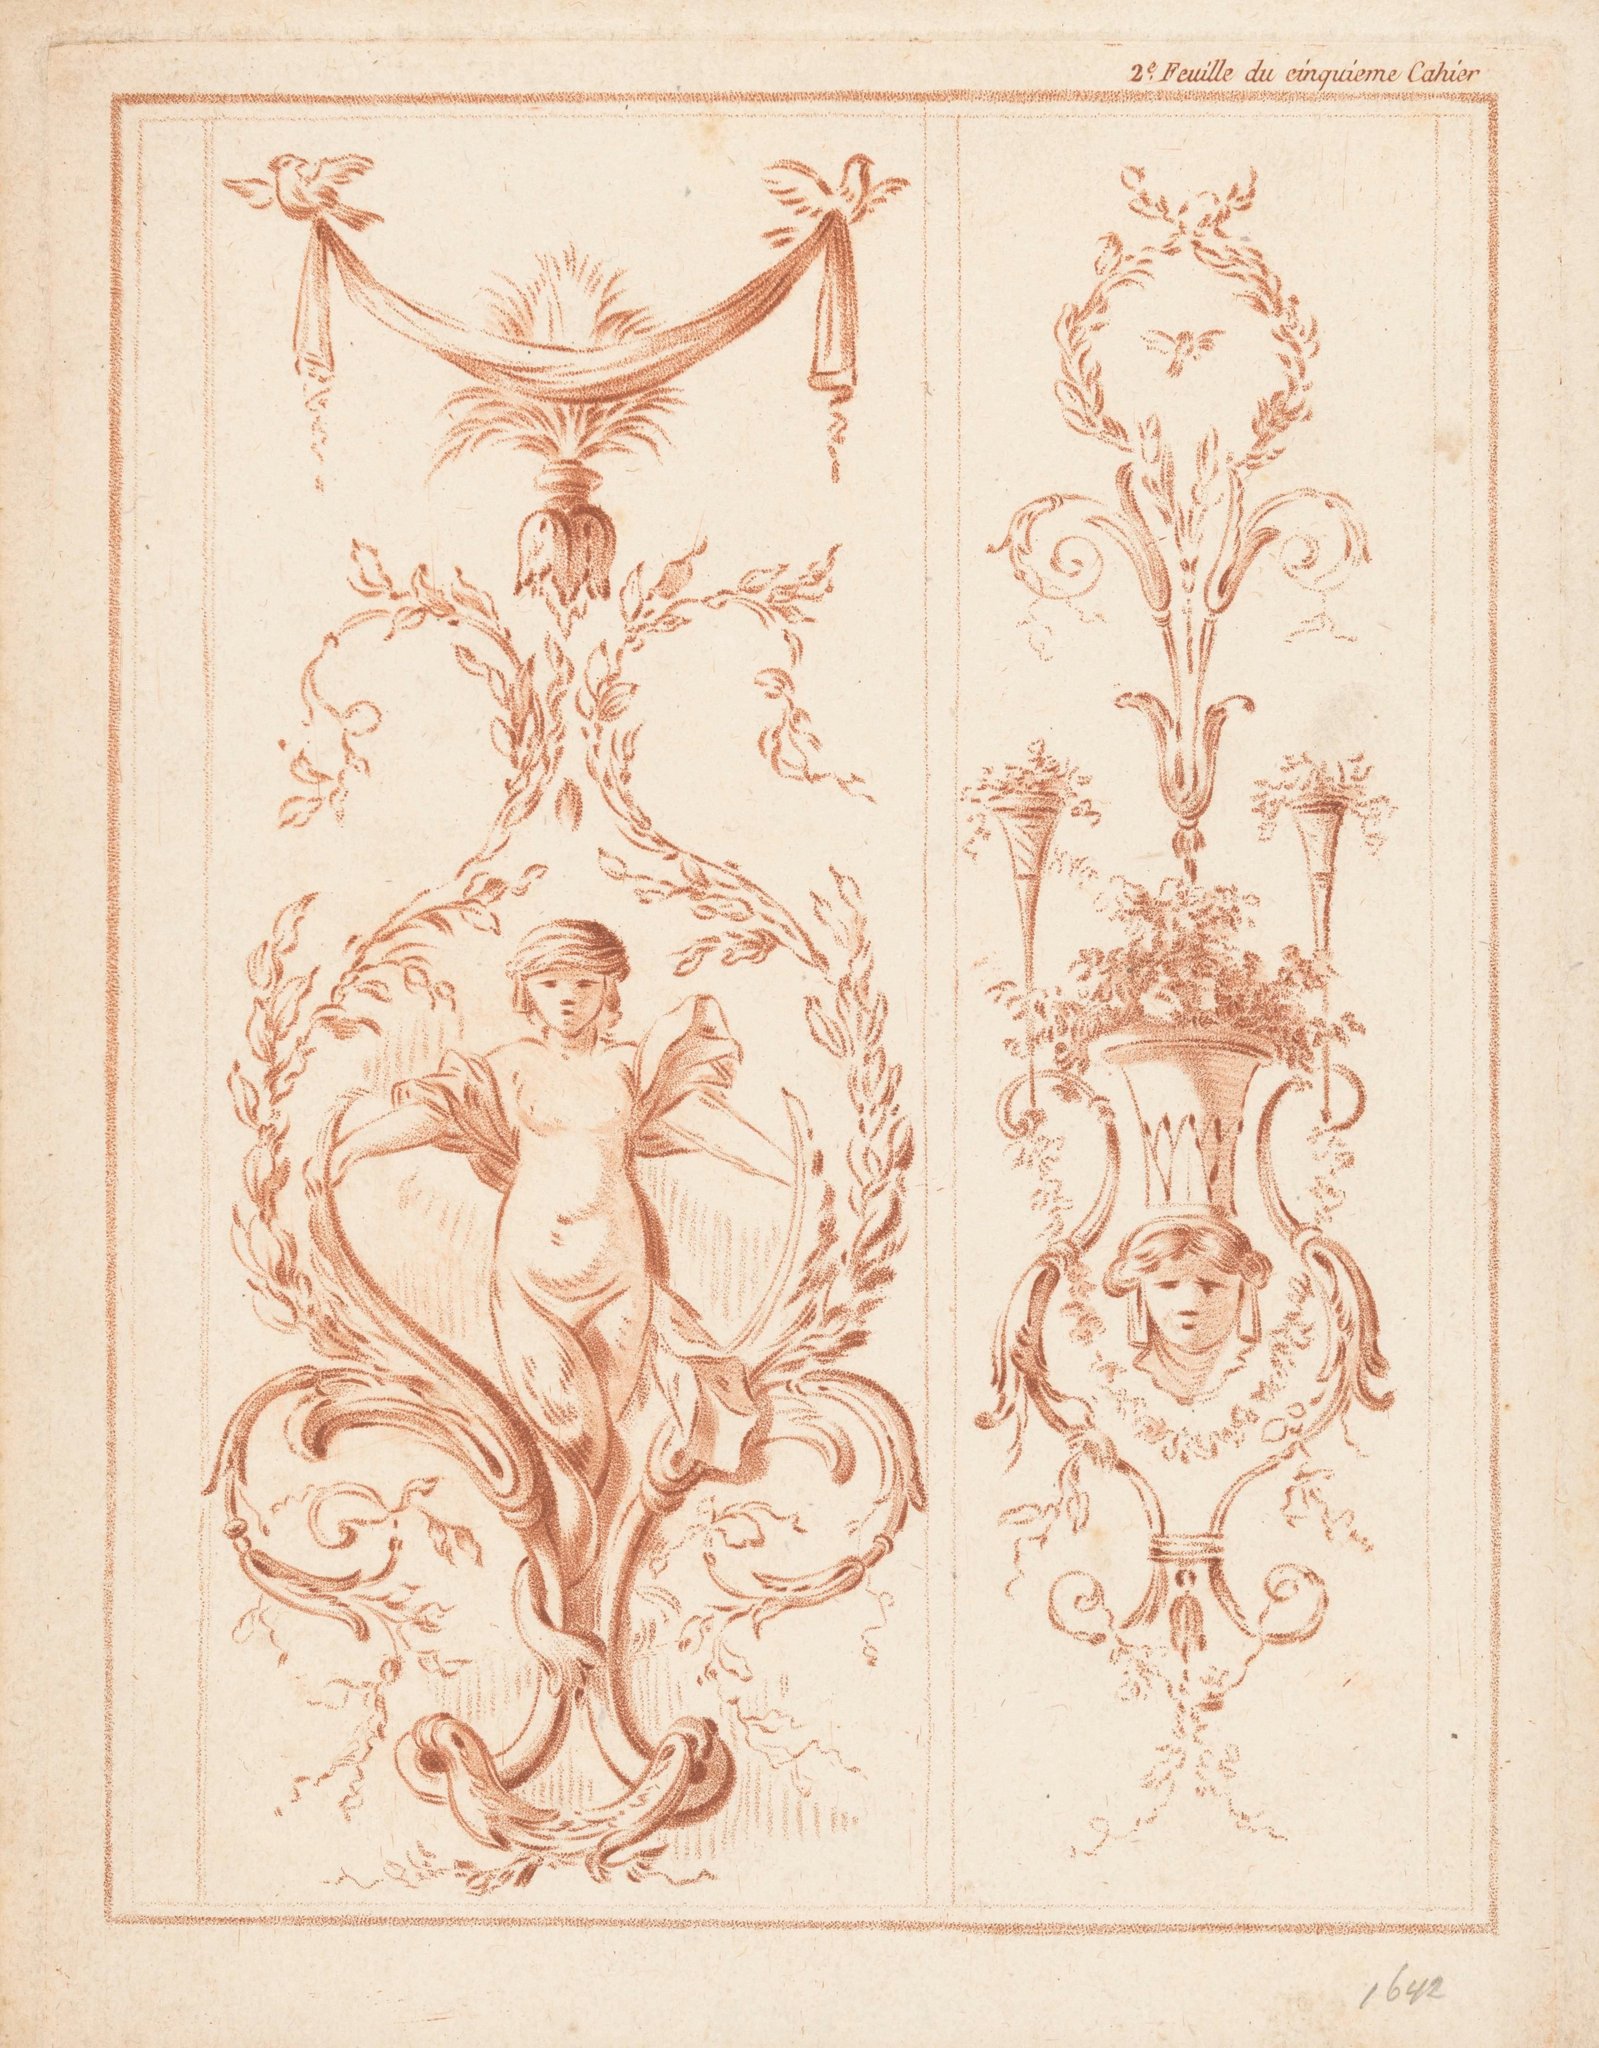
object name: ornament print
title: Cinquième Cahier des Arabesques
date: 1770-1780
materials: paper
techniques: printmaking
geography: paris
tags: ornament ~ arabesque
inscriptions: collector's mark: Lugt 2228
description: Twee panelen met arabesken. Rechts een vrouwenhoofd met bloemenmand en ranken. Links een vrouw met ranken en aan de bovenzijde een draperie vastgehouden door duiven.